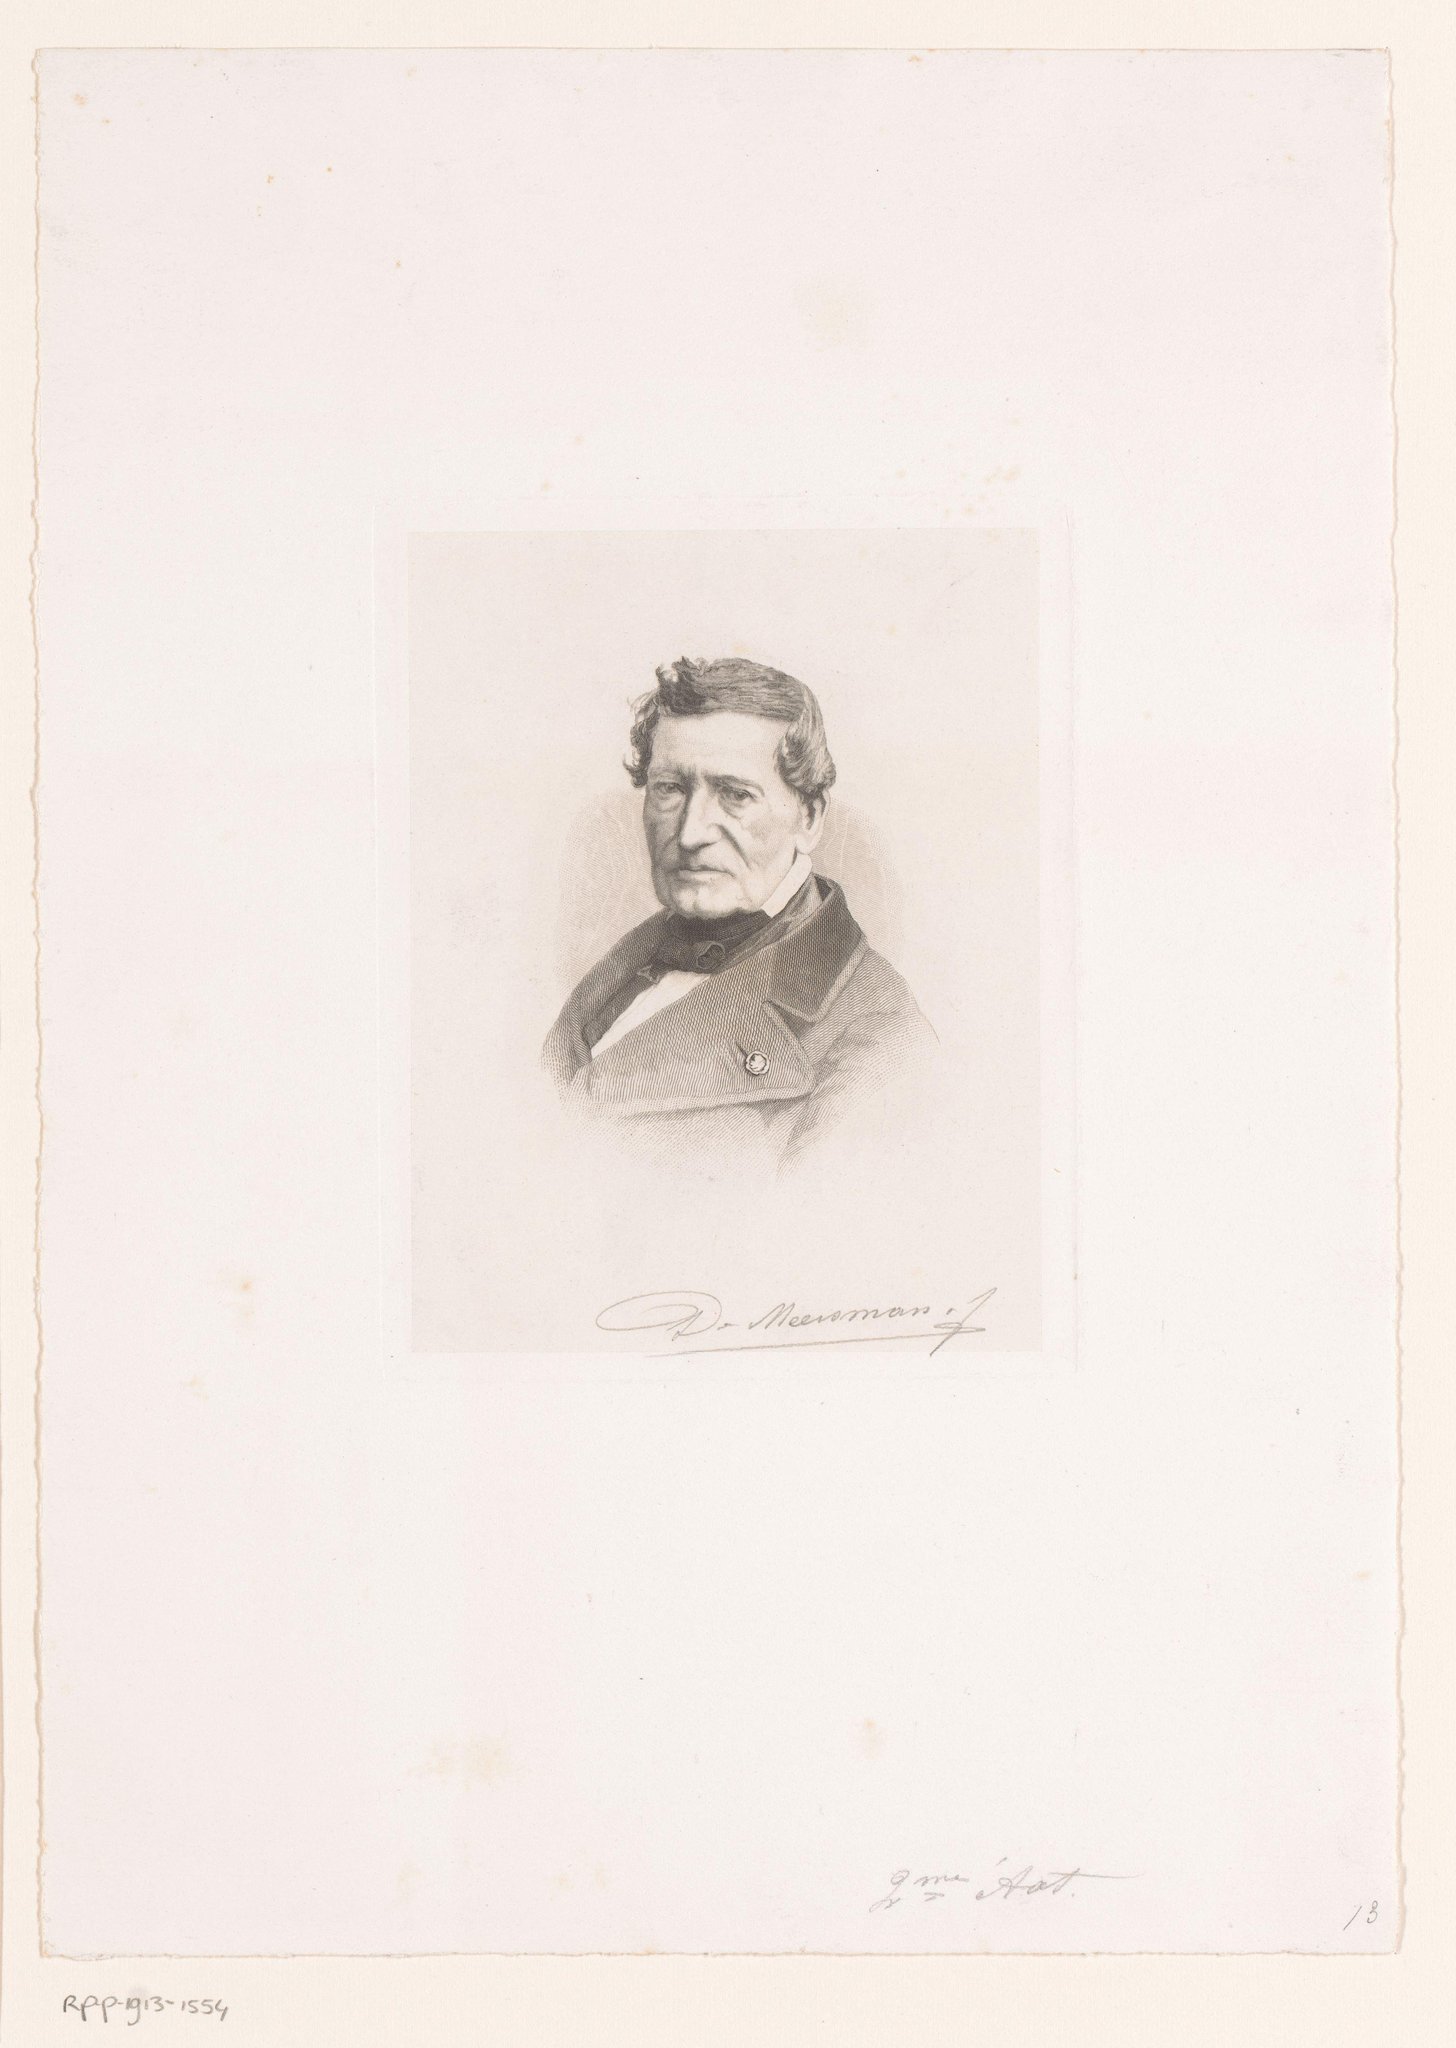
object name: print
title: Portret van een onbekende man, mogelijk Daupoigne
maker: françois de meersman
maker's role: print maker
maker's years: 1830-1905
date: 1840-1905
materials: paper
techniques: engraving, etching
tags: adult man, historical persons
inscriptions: inscription: ‘2me état’, collector's mark: Lugt 2228